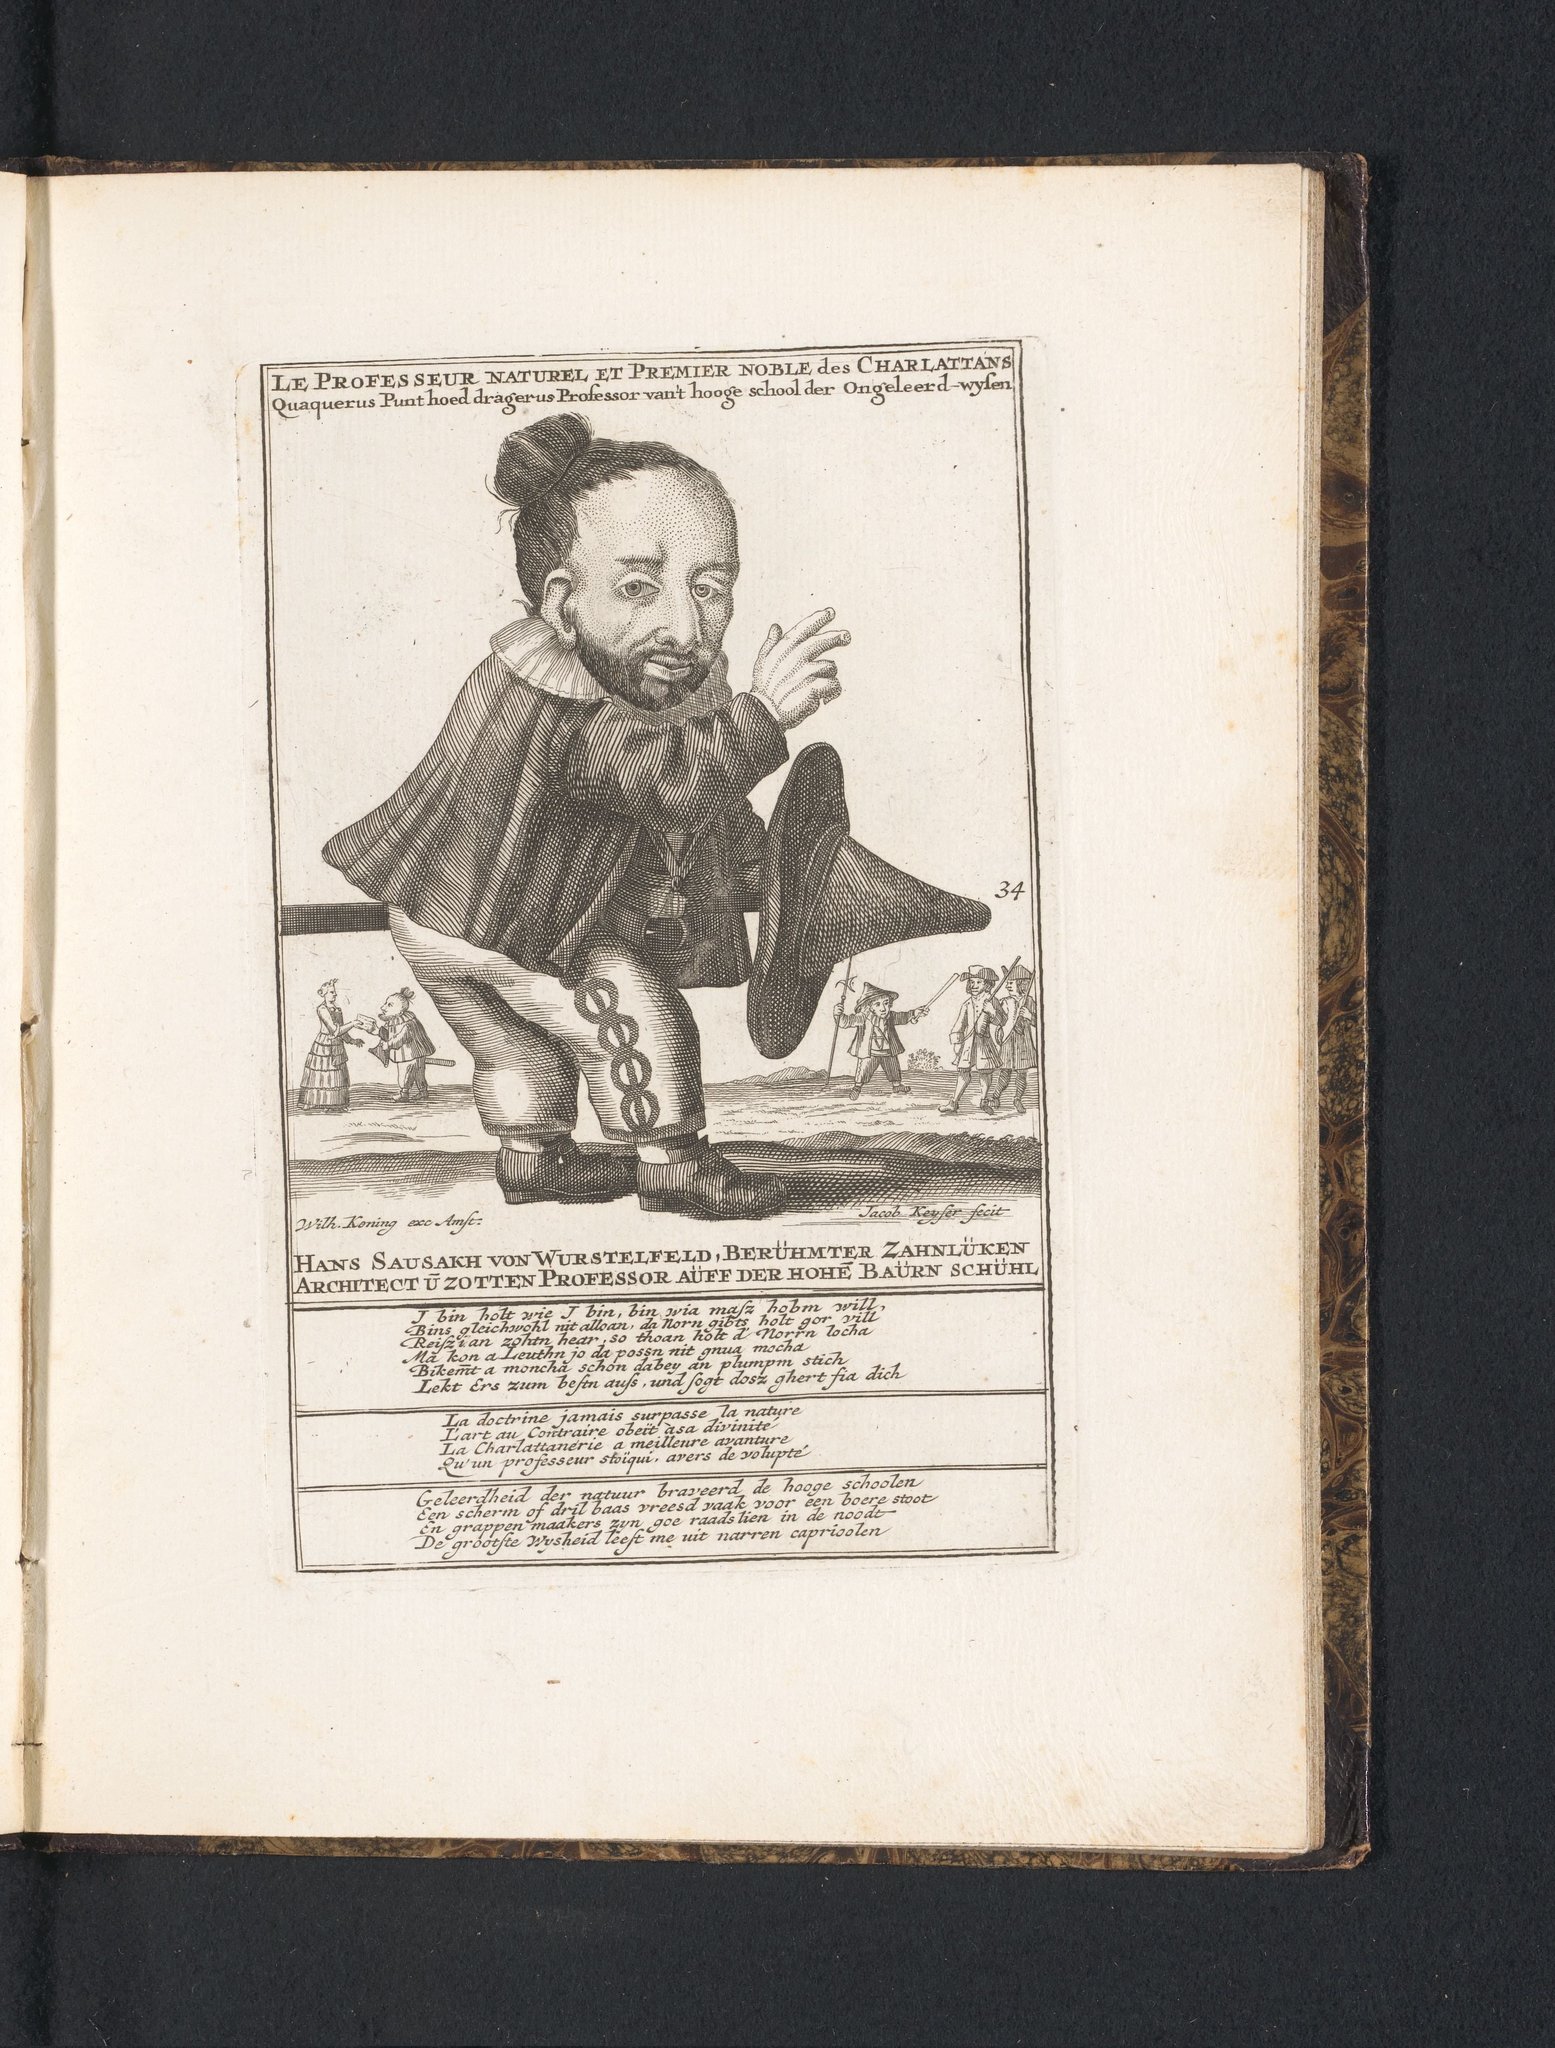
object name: print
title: De dwerg Quaquerus Punthoed, 1720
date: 1718-1720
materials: paper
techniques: etching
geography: amsterdam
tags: caricatures (human types), little people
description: De kleine mens Quaquerus Punthoed als architect en professor op de hogere boerenschool. In het onderschrift verzen in het Duits, Frans en Nederlands. Genummerd rechts midden: 34. Onderdeel van deel II in de tweede Nederlandse gebonden uitgave uit 1720 (en gerelateerd aan de Windhandel in dat jaar) van een serie karikaturen van kleine mensen, bekend als Het Dwergentooneel.